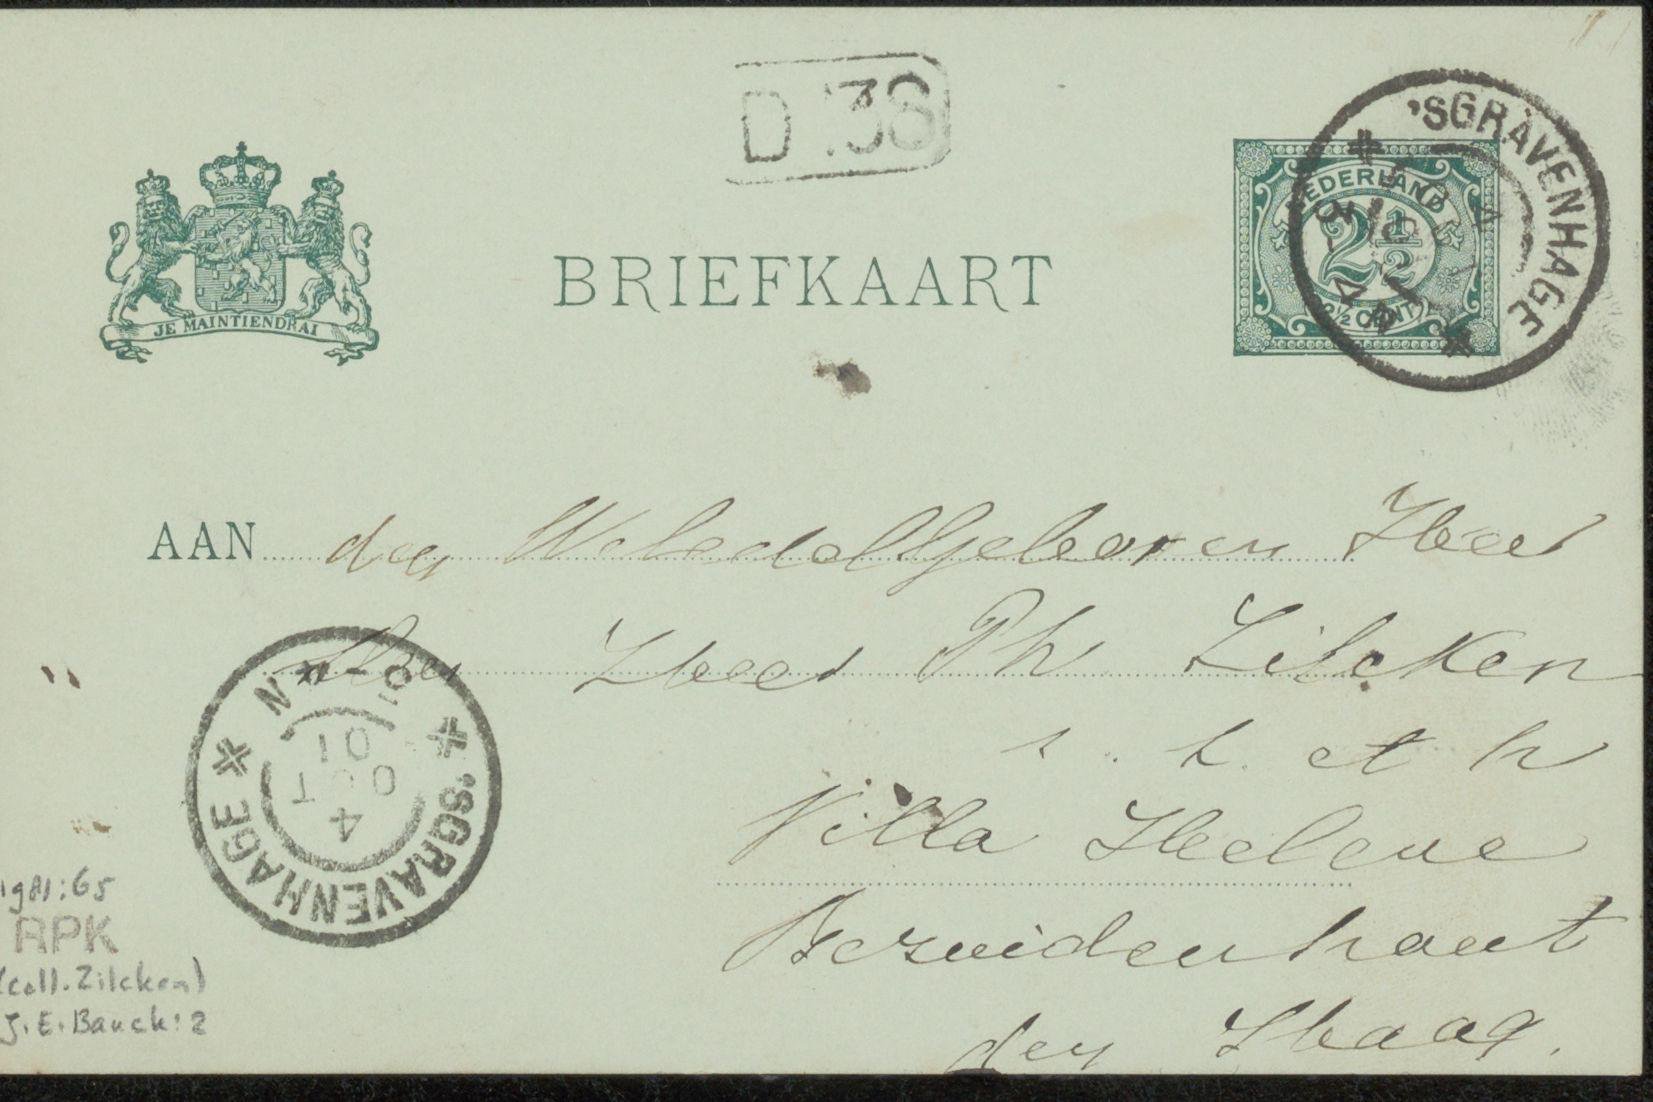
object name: postcard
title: Briefkaart aan Philip Zilcken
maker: j.e. bauck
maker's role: schrijver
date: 1901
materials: cardboard, ink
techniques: pen, writing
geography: the hague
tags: painter, draughtsman, philip zilcken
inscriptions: collector's mark: ‘RPK’